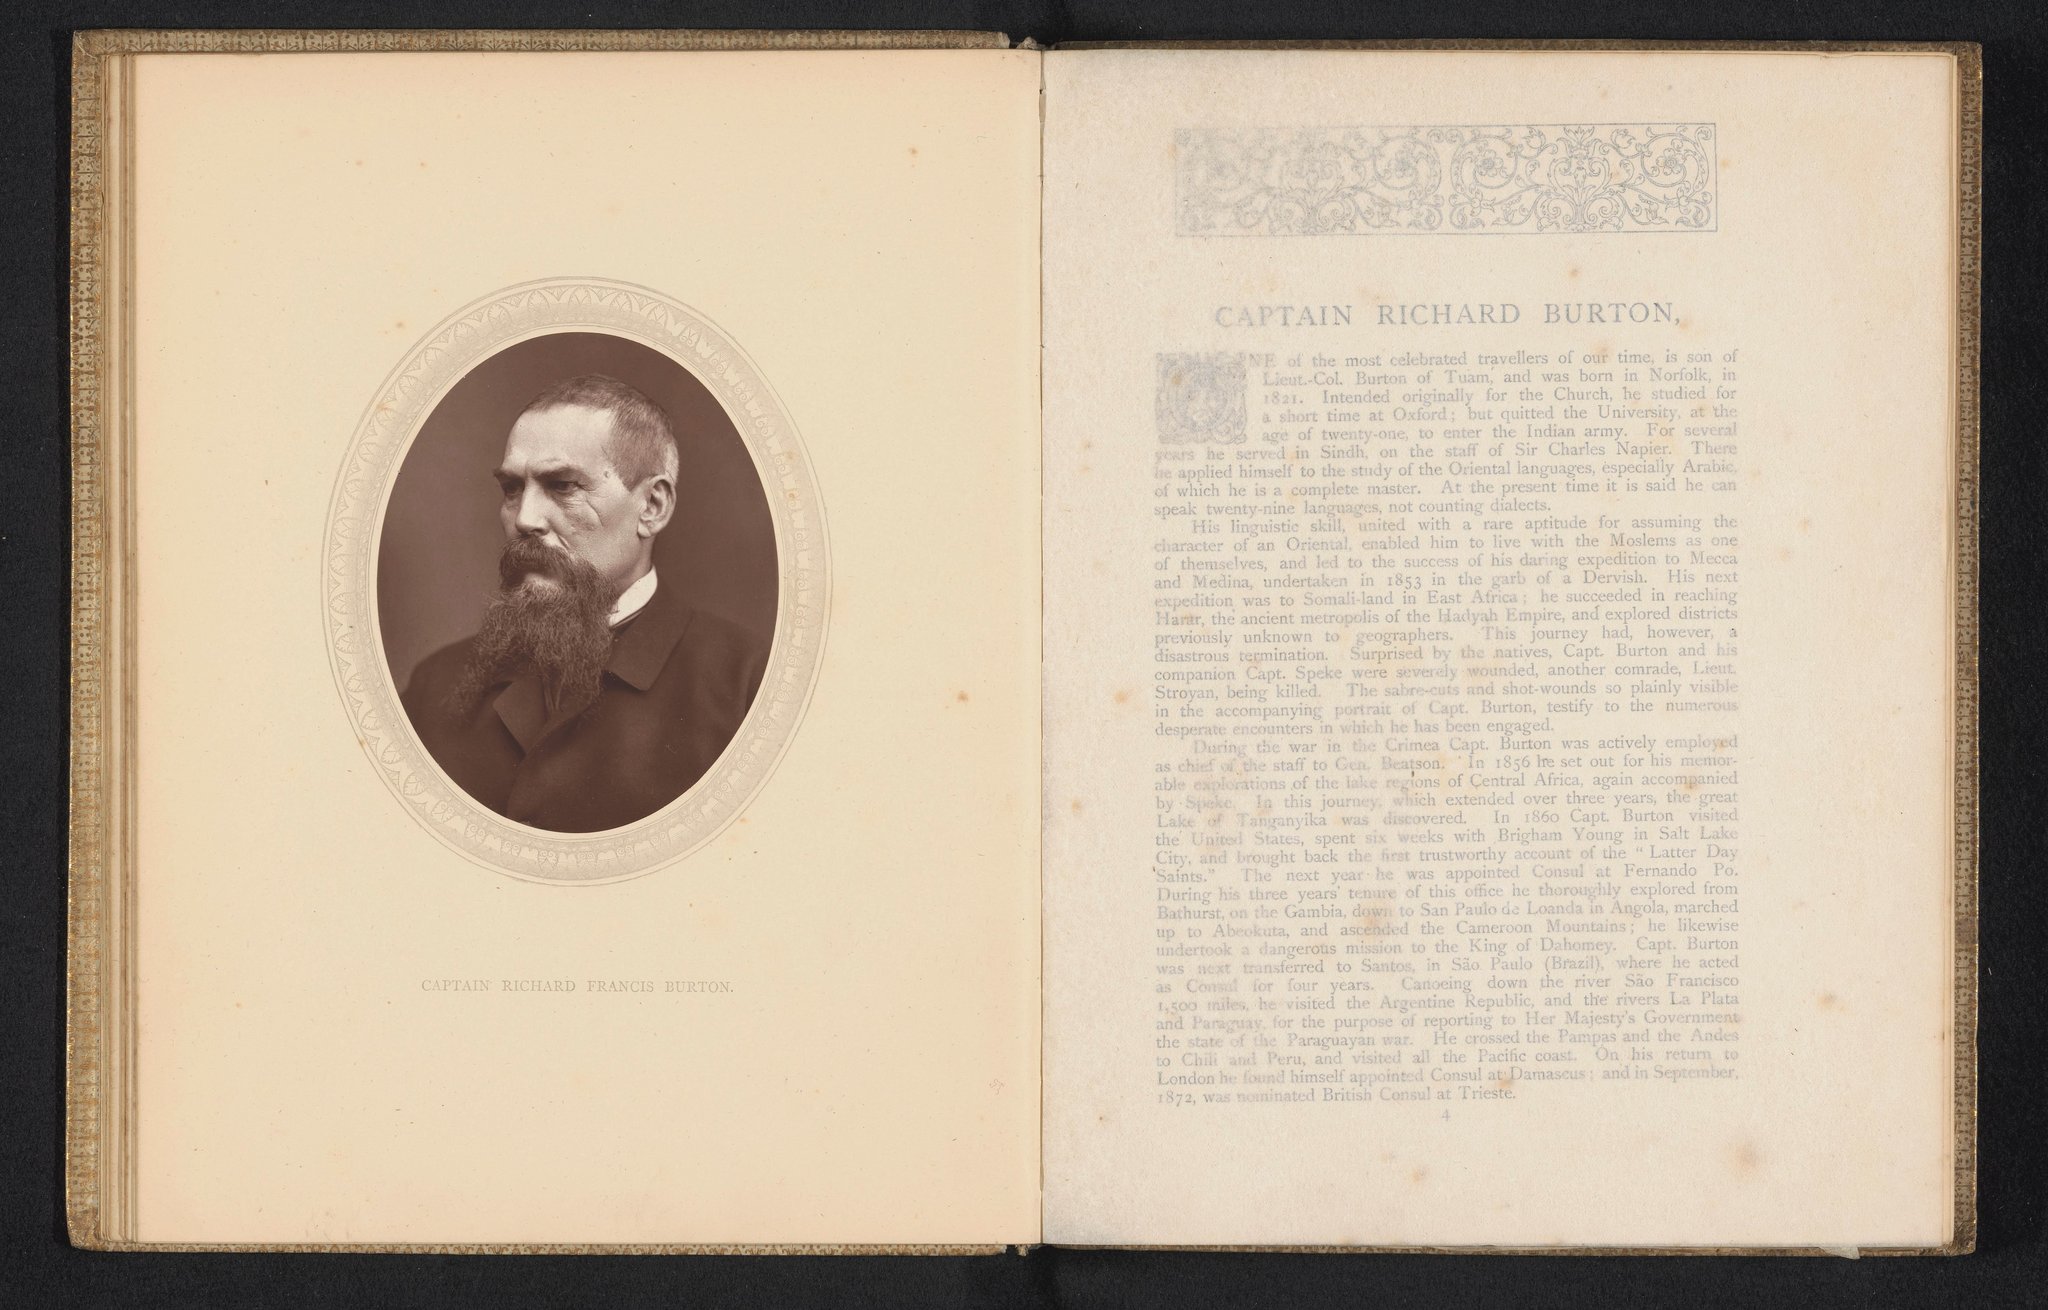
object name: page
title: Captain Richard Francis Burton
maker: Anonymous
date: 1871-1876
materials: paper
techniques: woodburytype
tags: historical persons (portraits and scenes from the life) (+ (full) bust portrait), explorer